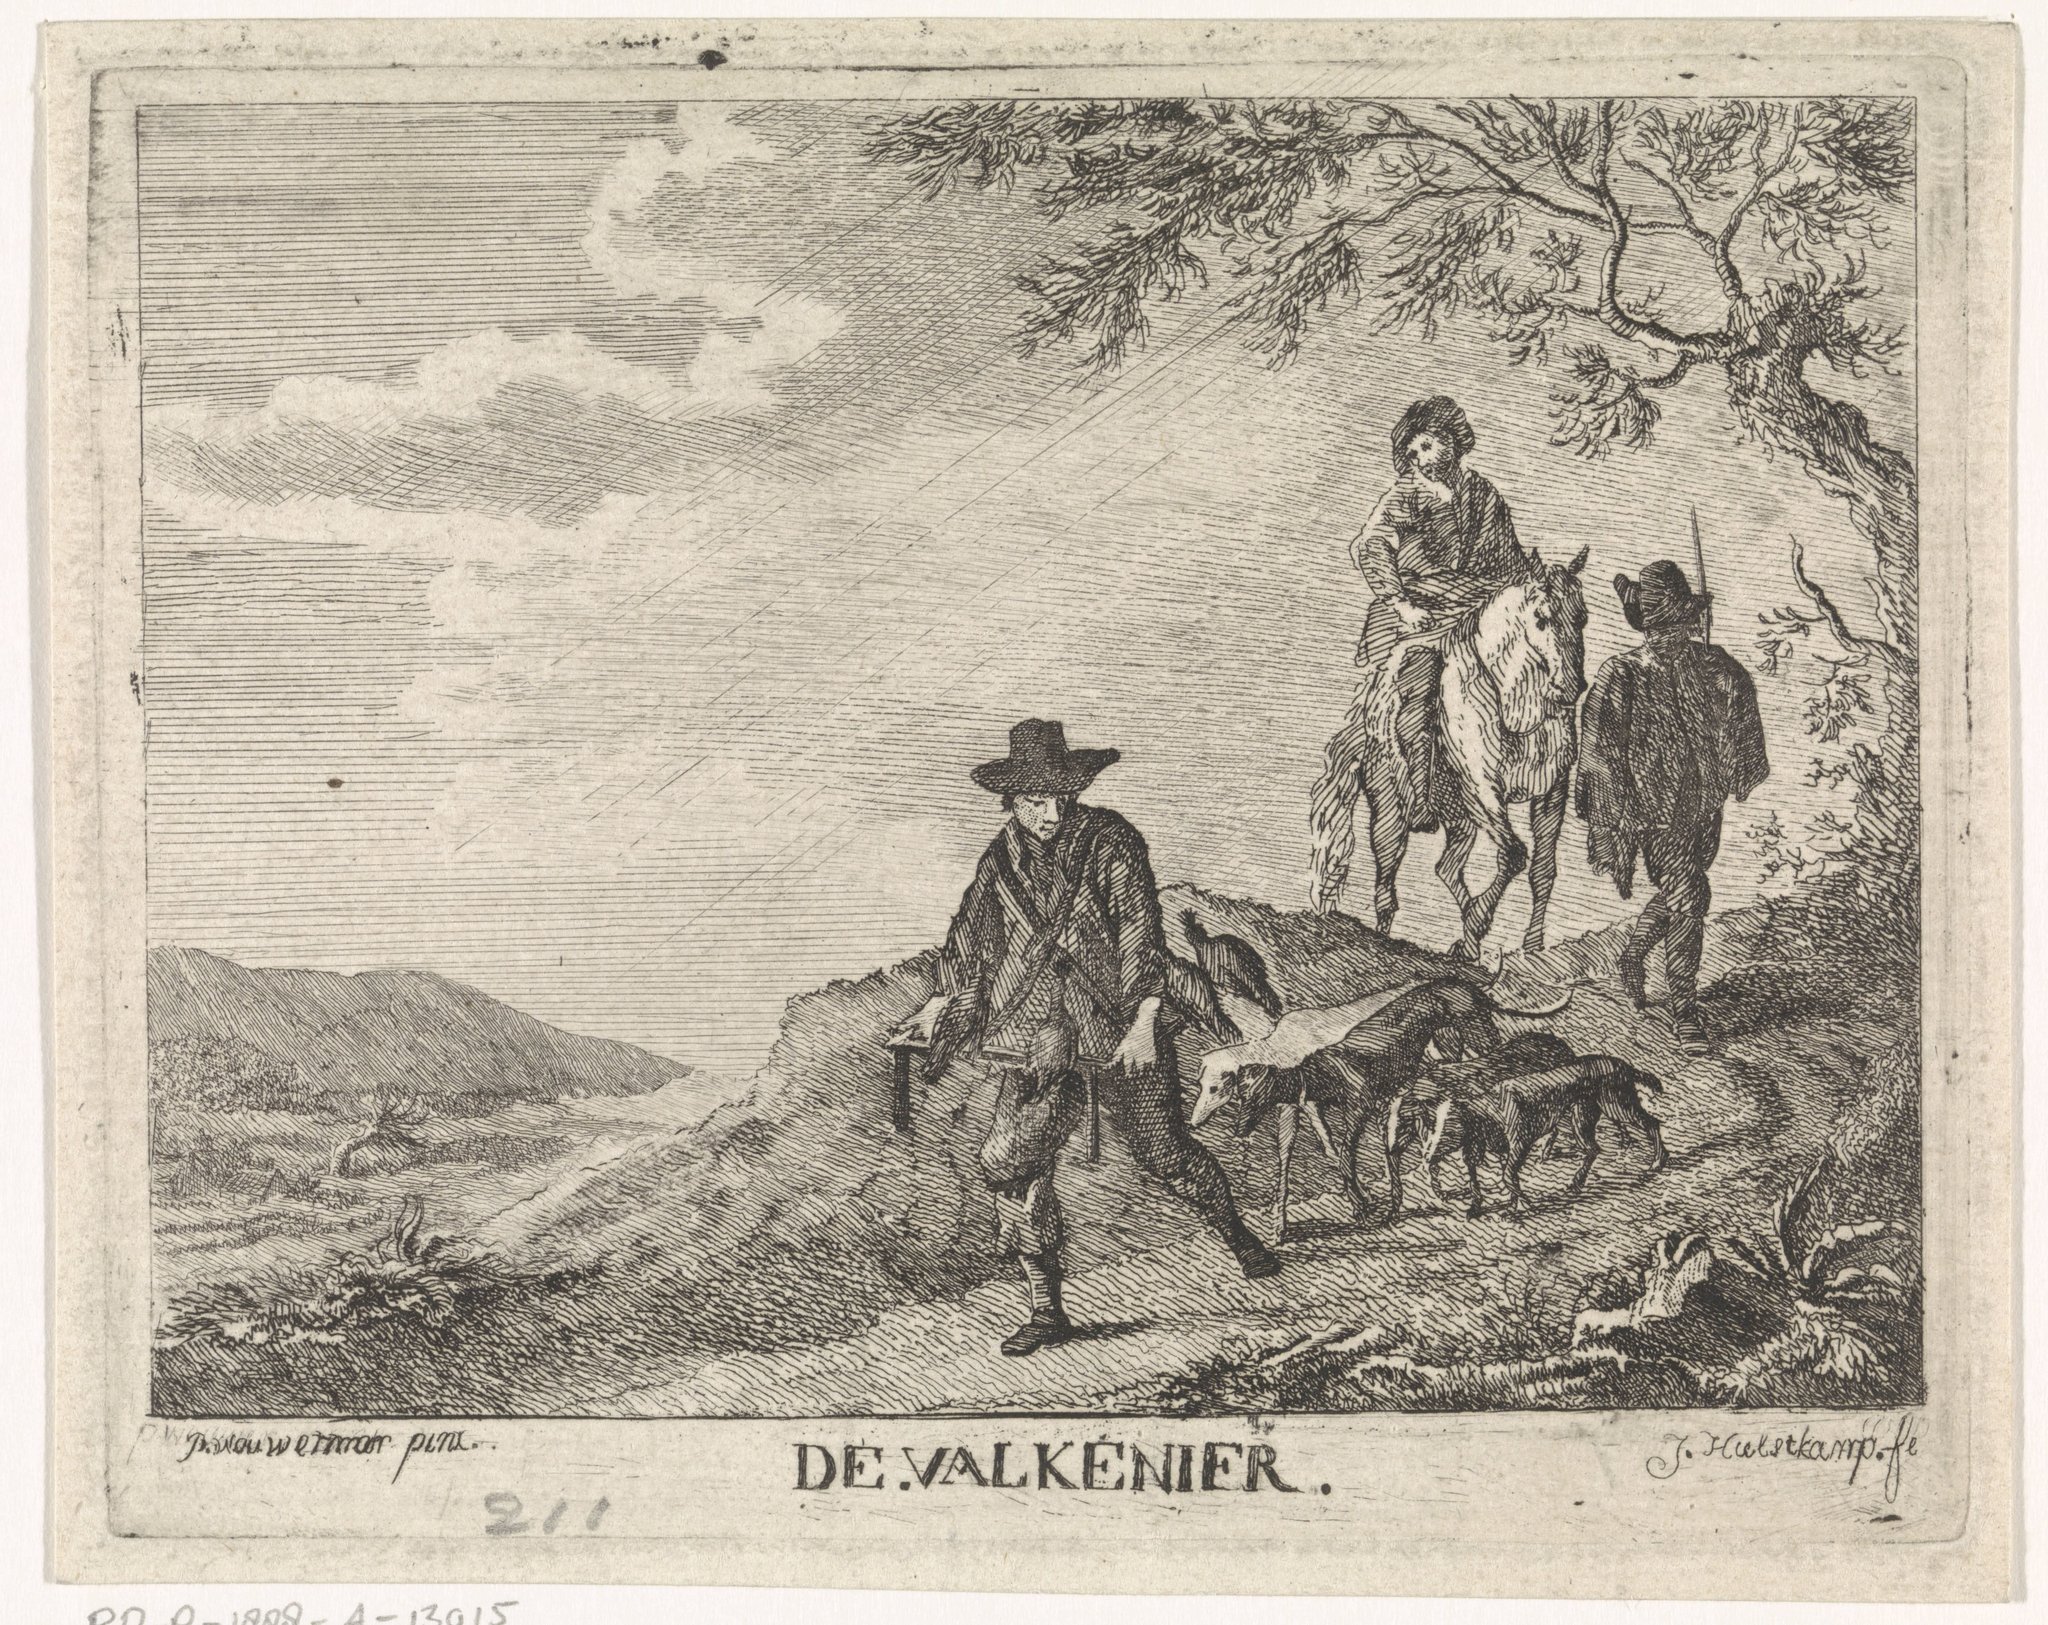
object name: print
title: Valkenier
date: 1774-1786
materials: paper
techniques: etching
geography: rotterdam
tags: predatory birds: falcon, hunting dogs, fowling, fowler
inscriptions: collector's mark: Lugt 2228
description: Middenvoor een valkenier, lopend in landschap, gevolgd door drie honden. Rechts rijdt een ruiter, rechts naast hem een wandelende man.